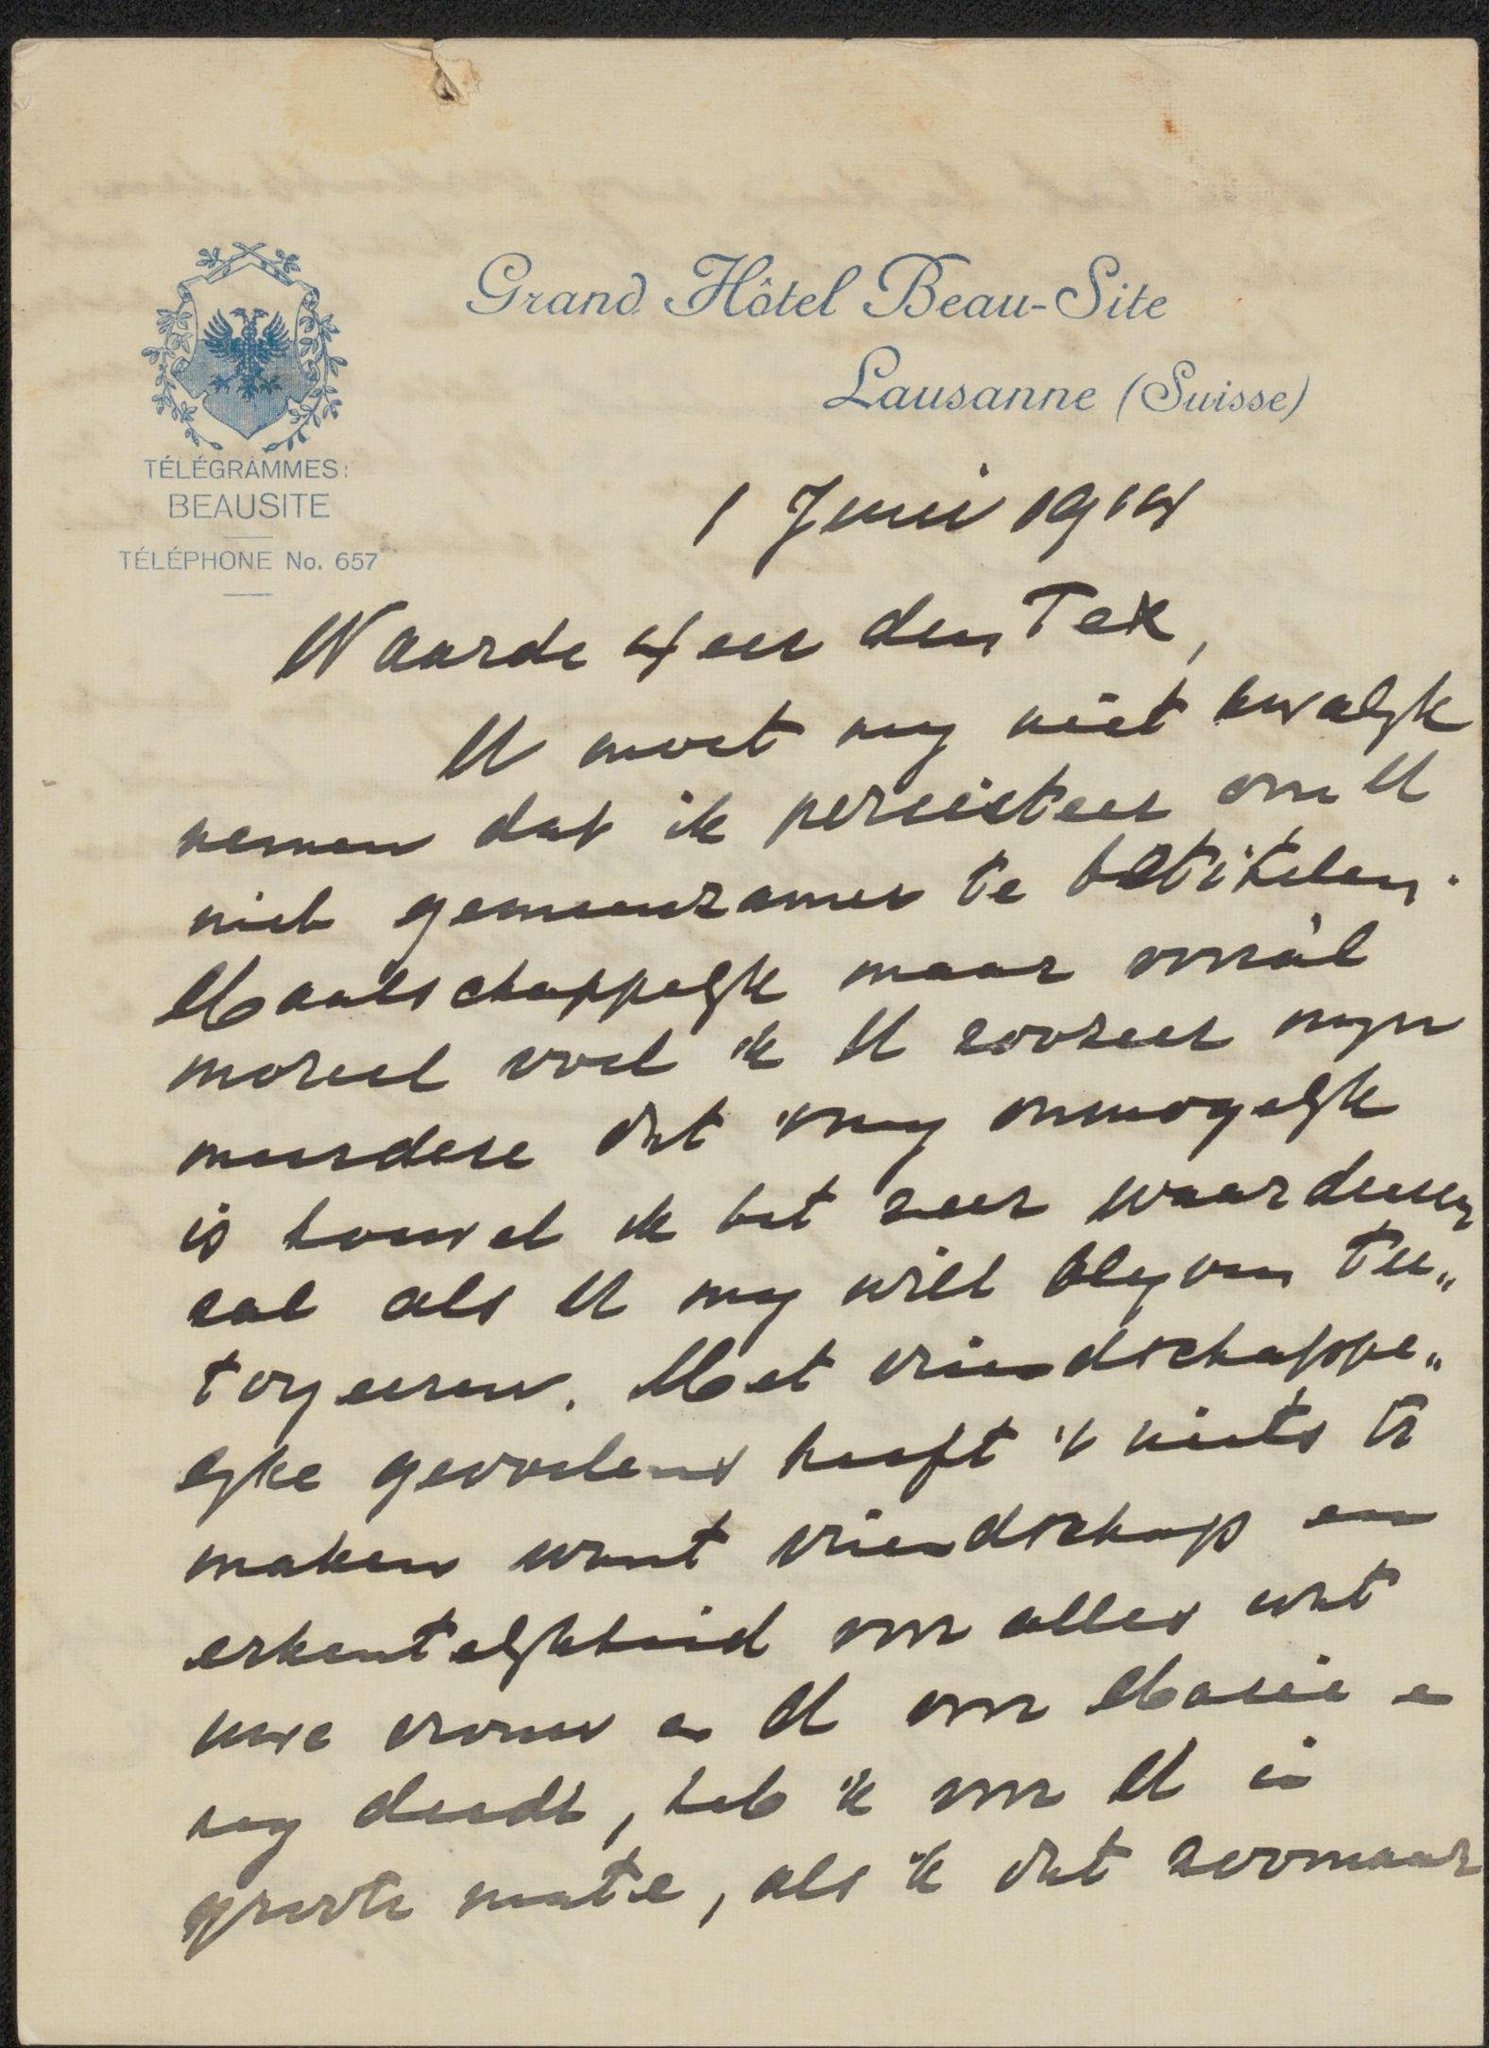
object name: letter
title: Brief aan de heer Den Tex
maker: willem witsen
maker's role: draughtsman, painter, print maker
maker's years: 1860-1923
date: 1914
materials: ink, paper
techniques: pen, printing, writing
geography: lausanne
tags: amsterdam, augusta maria agnes witsen-schorr, family life, venice